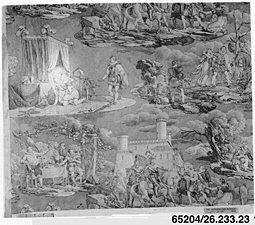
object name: furnishing textile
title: Henri IV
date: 1815-1825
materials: cotton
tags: human figures,buildings,kings,horses,trees